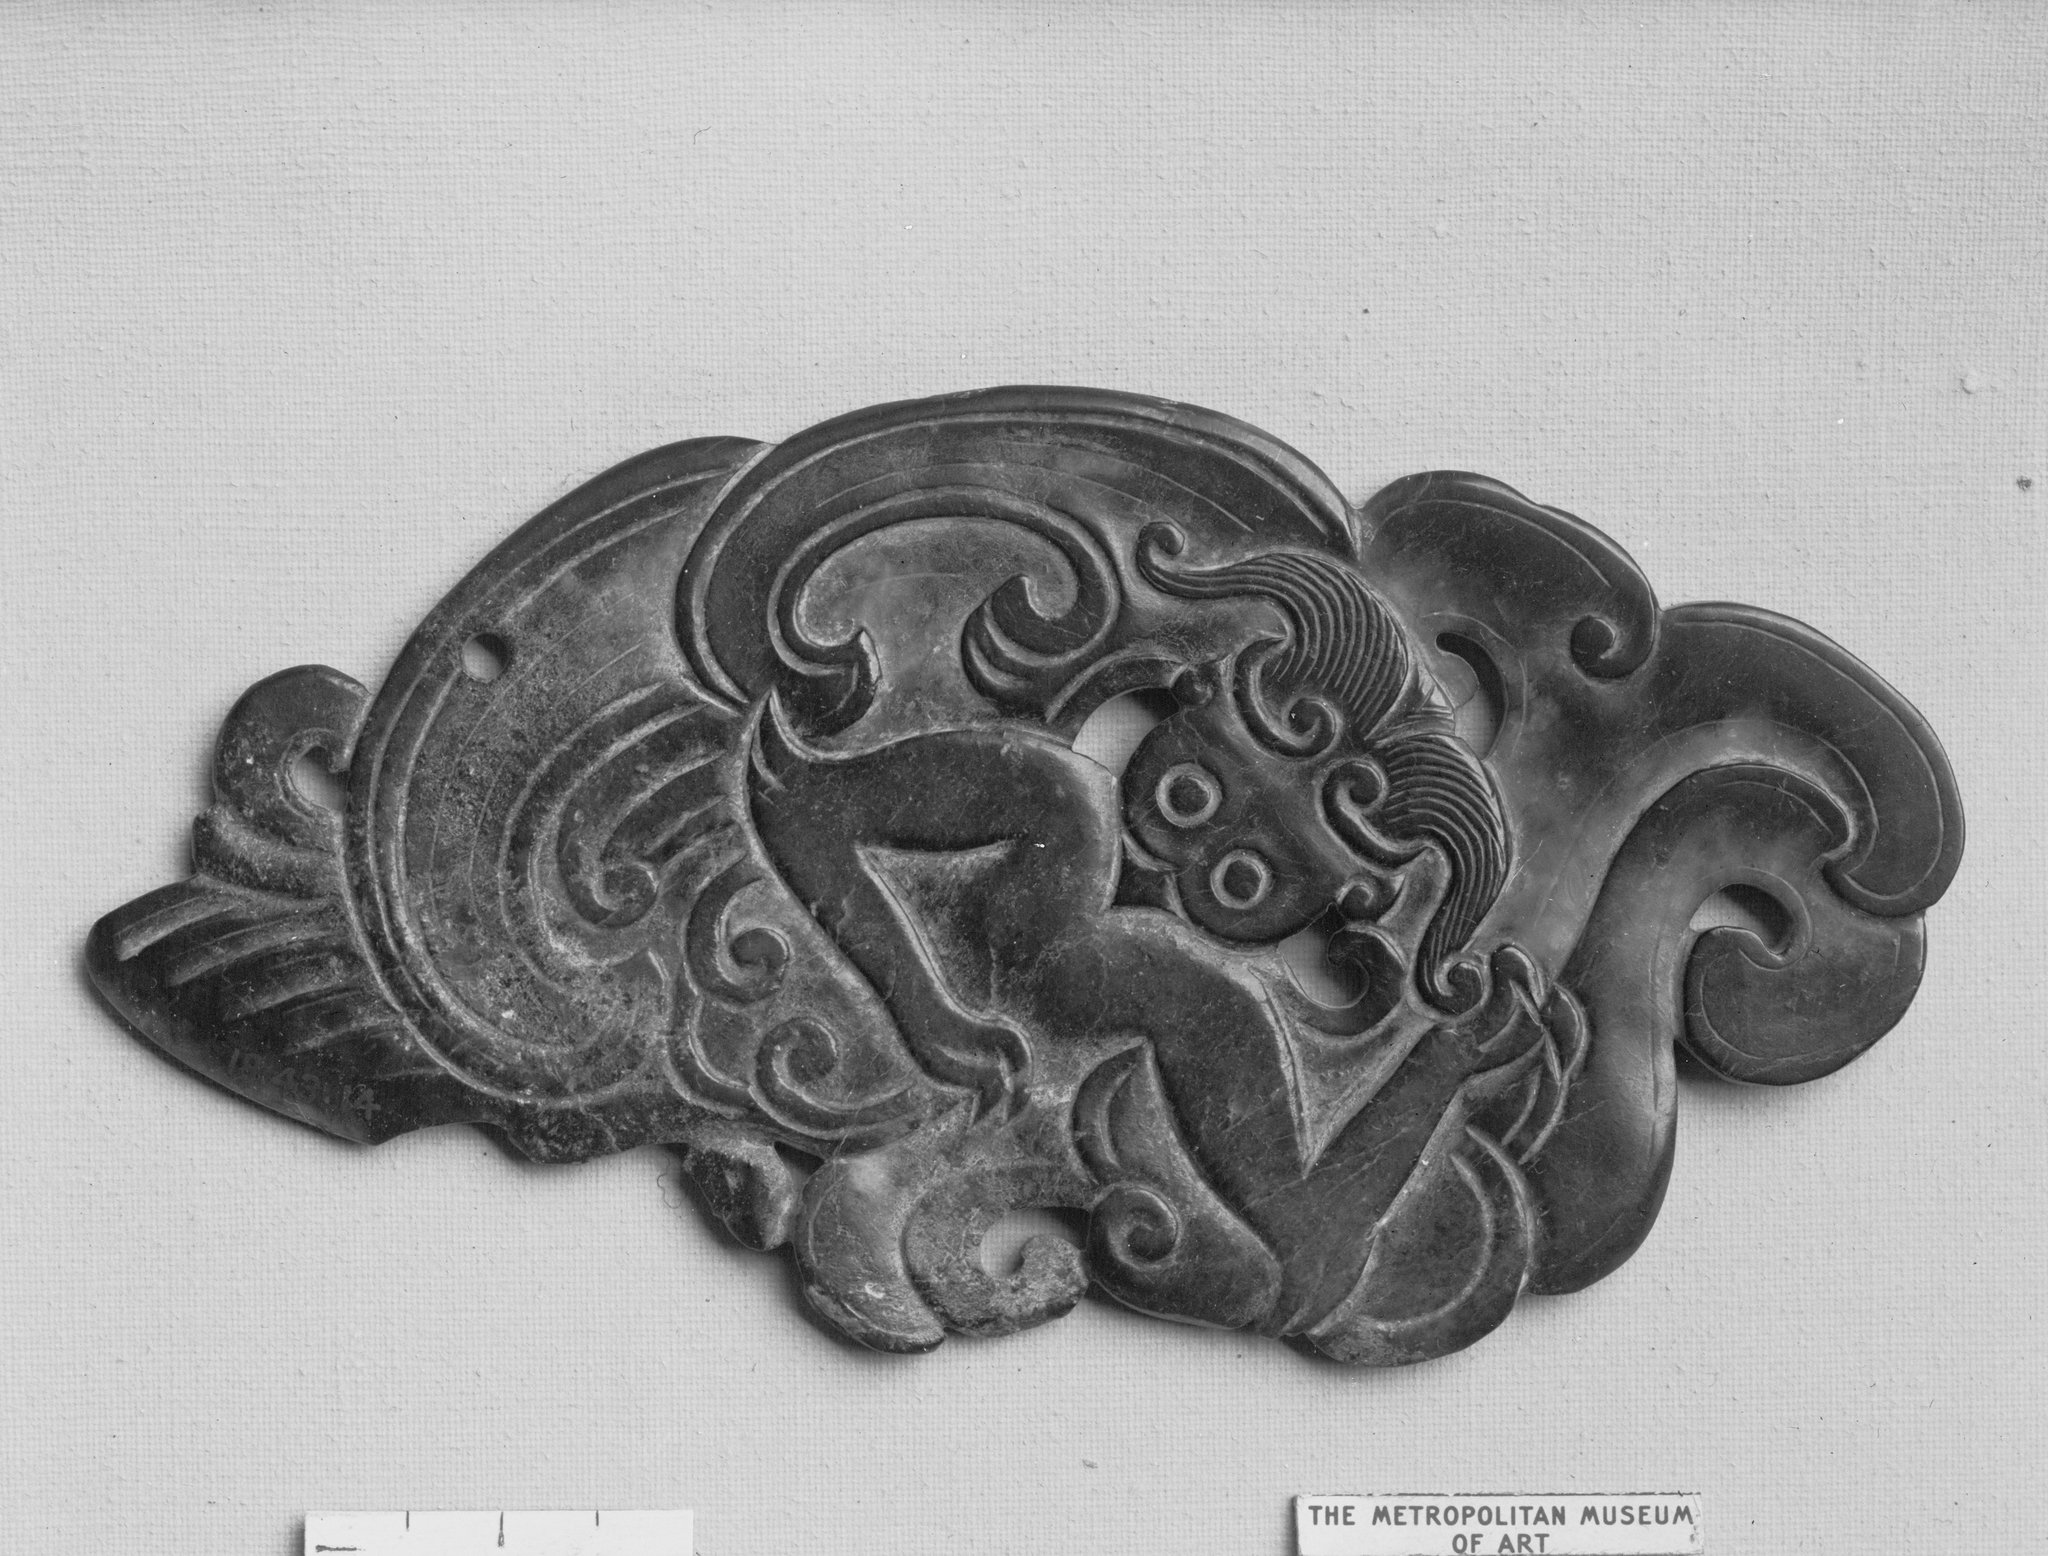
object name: ornament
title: Ornament: Love Token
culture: chinese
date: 206 BCE-220 CE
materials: jade